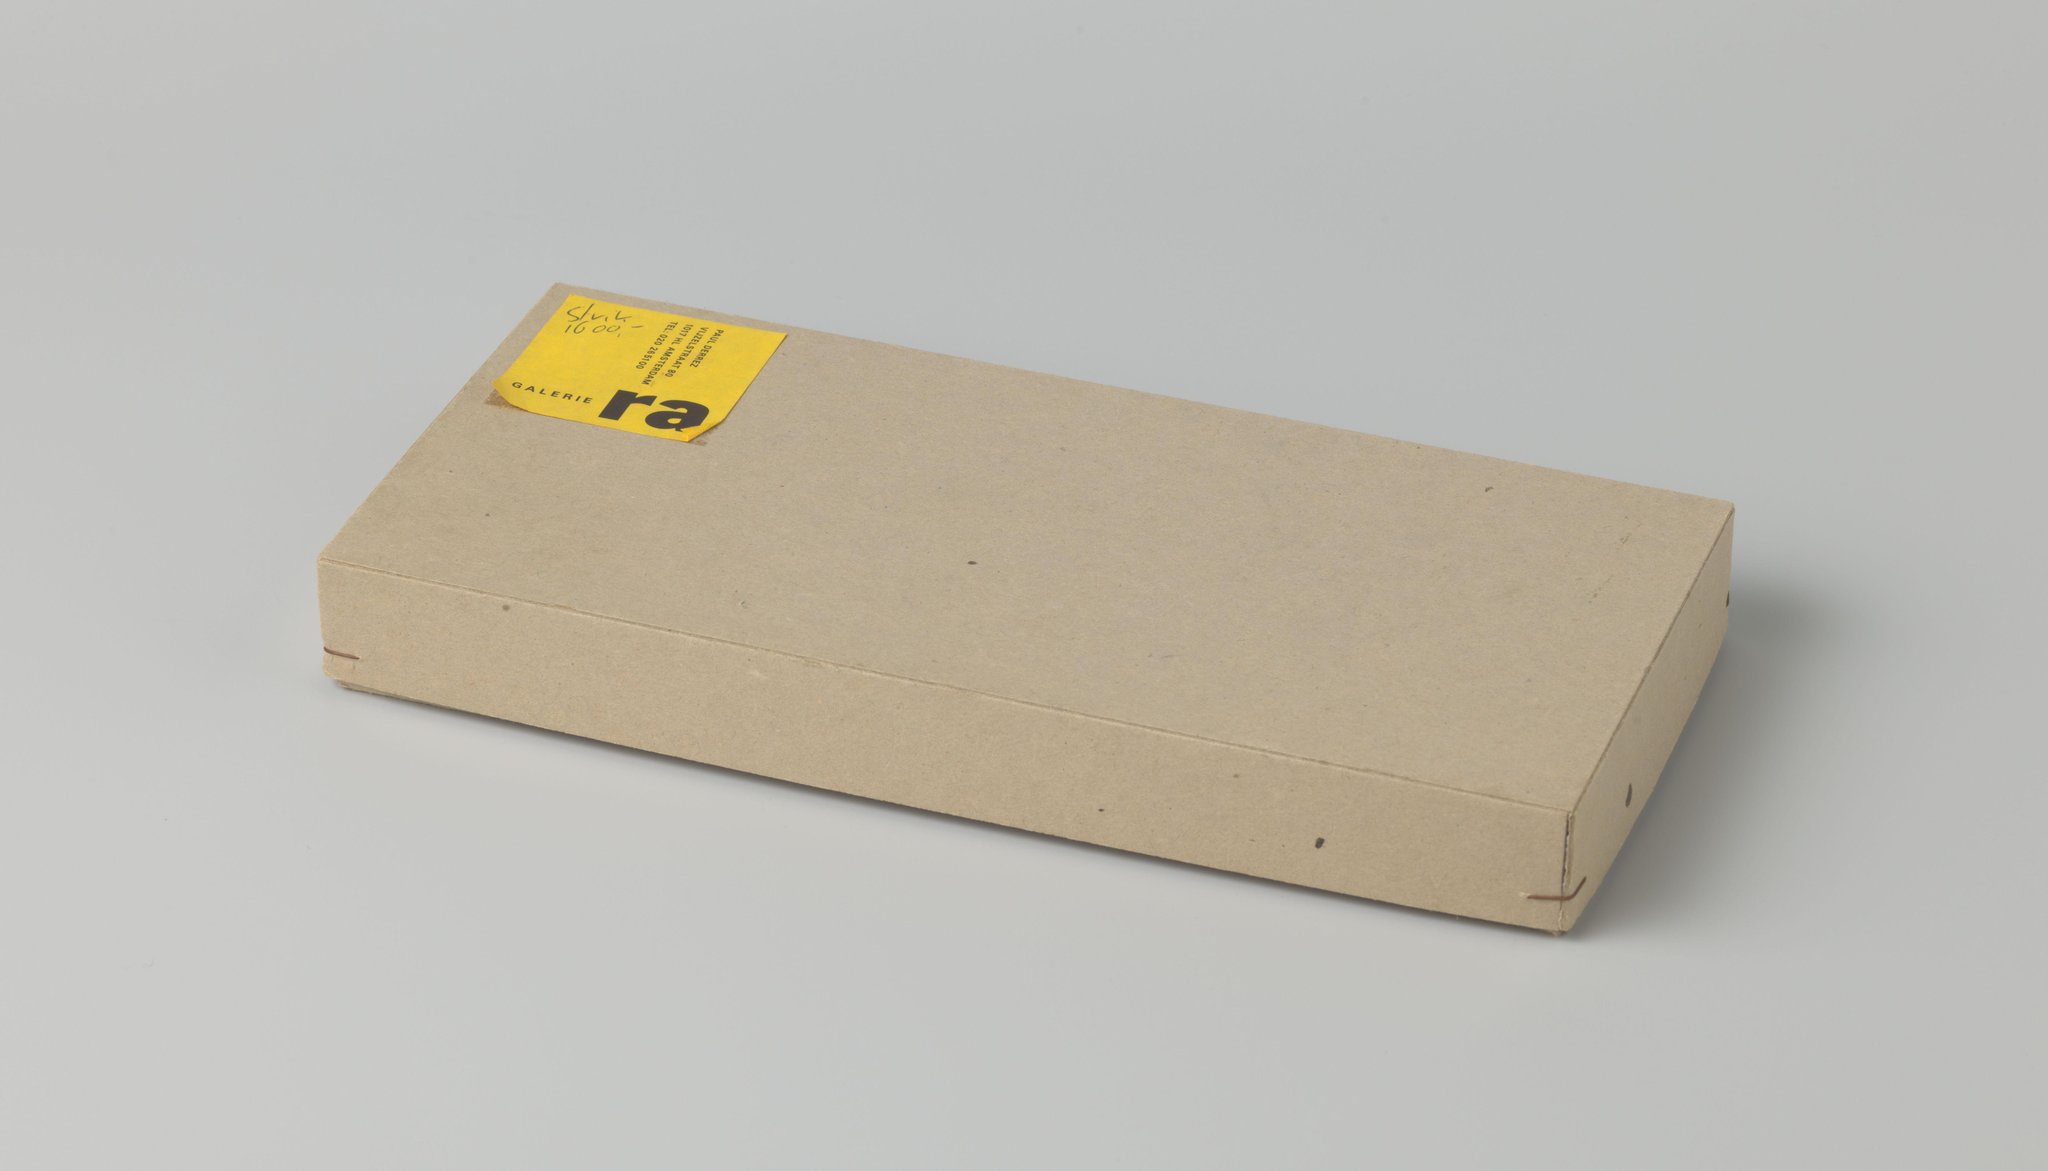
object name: box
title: Doos van drie Biba buttons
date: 1960-1980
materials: cardboard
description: Doos van karton met losse deksel voor Biba buttons BK-2010-2-472, BK-2010-2-473 en BK-2010-2-474.